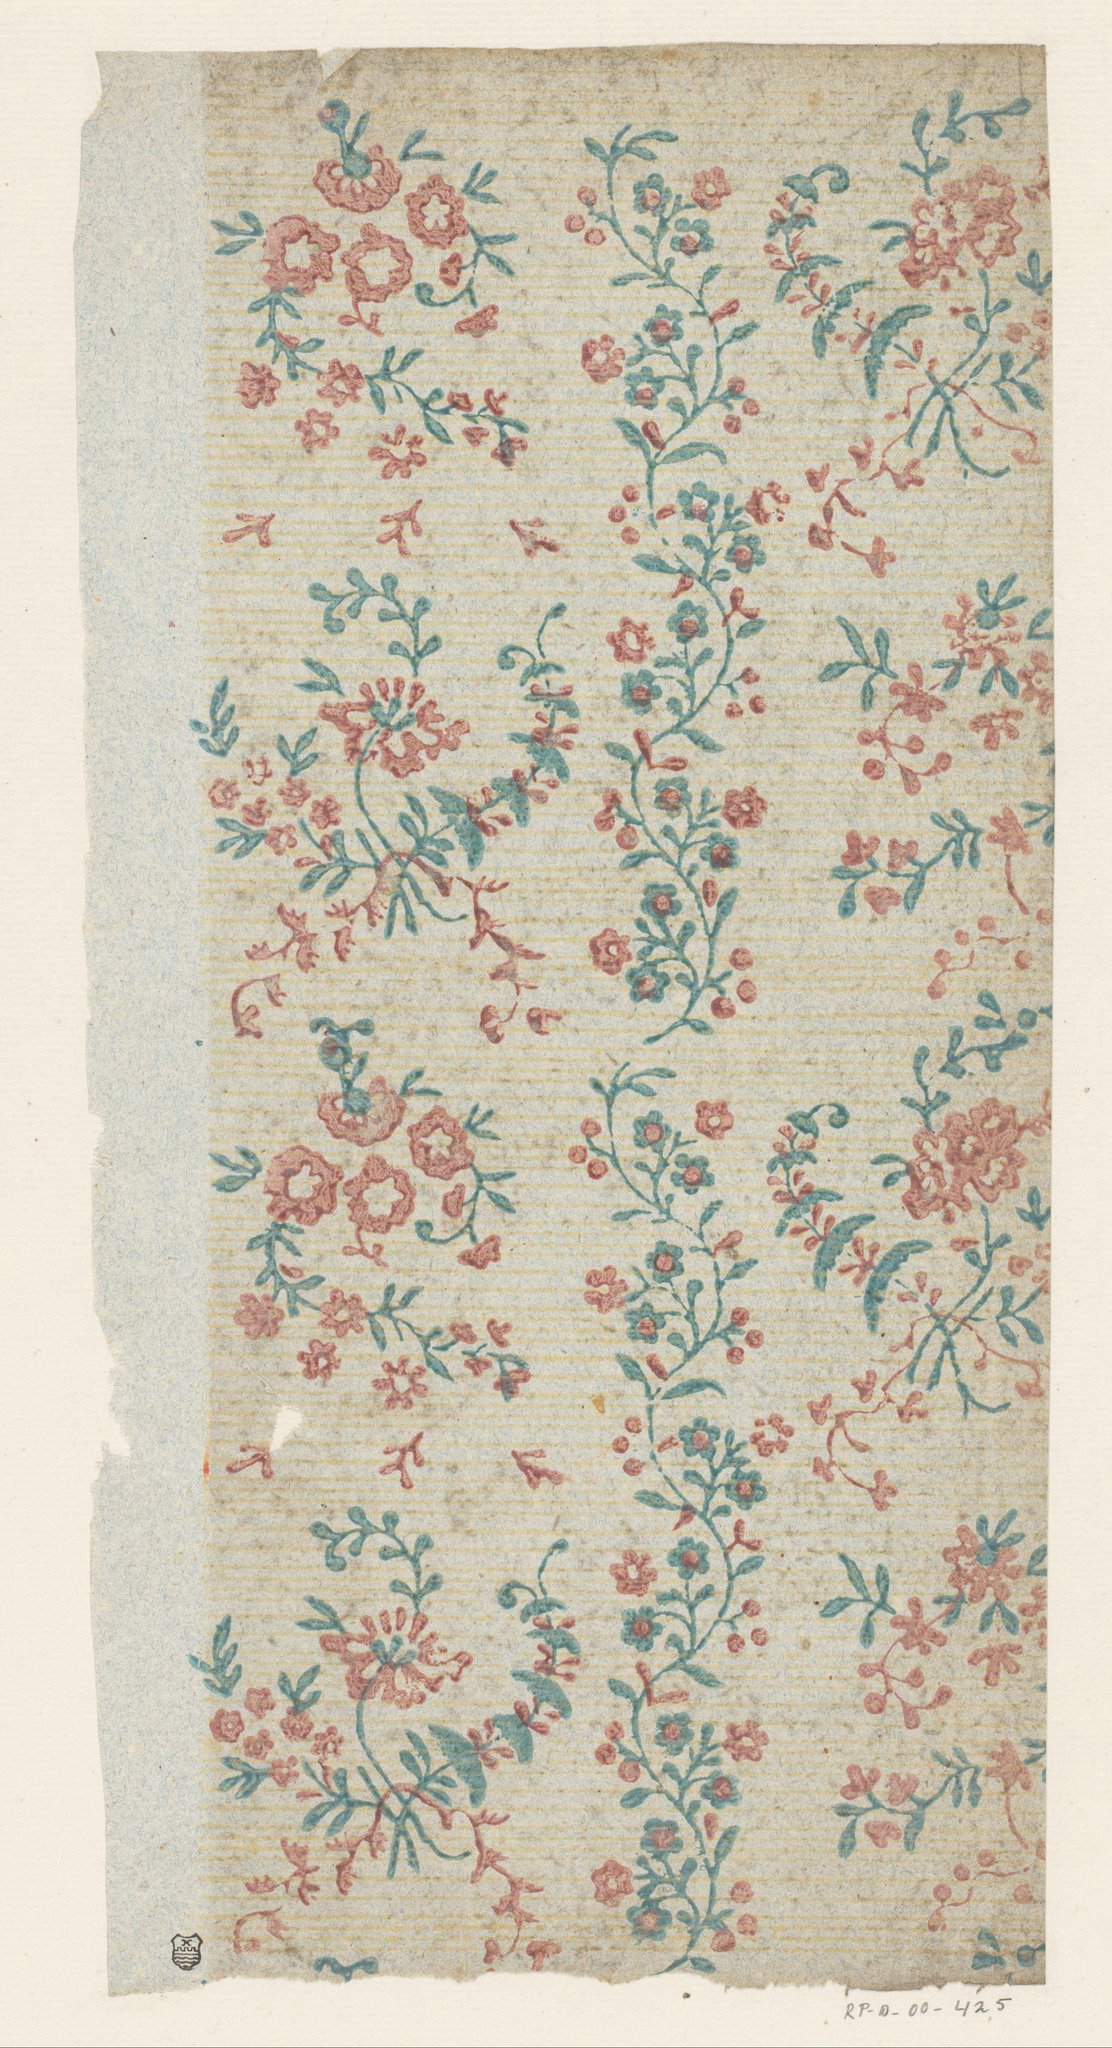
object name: printed paper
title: Blad met alternerend banenpatroon van slingerende rank en van bloemen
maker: Anonymous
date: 1700-1850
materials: paper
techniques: printing block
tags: ornament derived from plant forms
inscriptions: collector's mark: Lugt 2760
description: Blad met alternerend banenpatroon van slingerende bloemenrank en van losse boeketten op een doorlopend horizontaal lijnenfond.